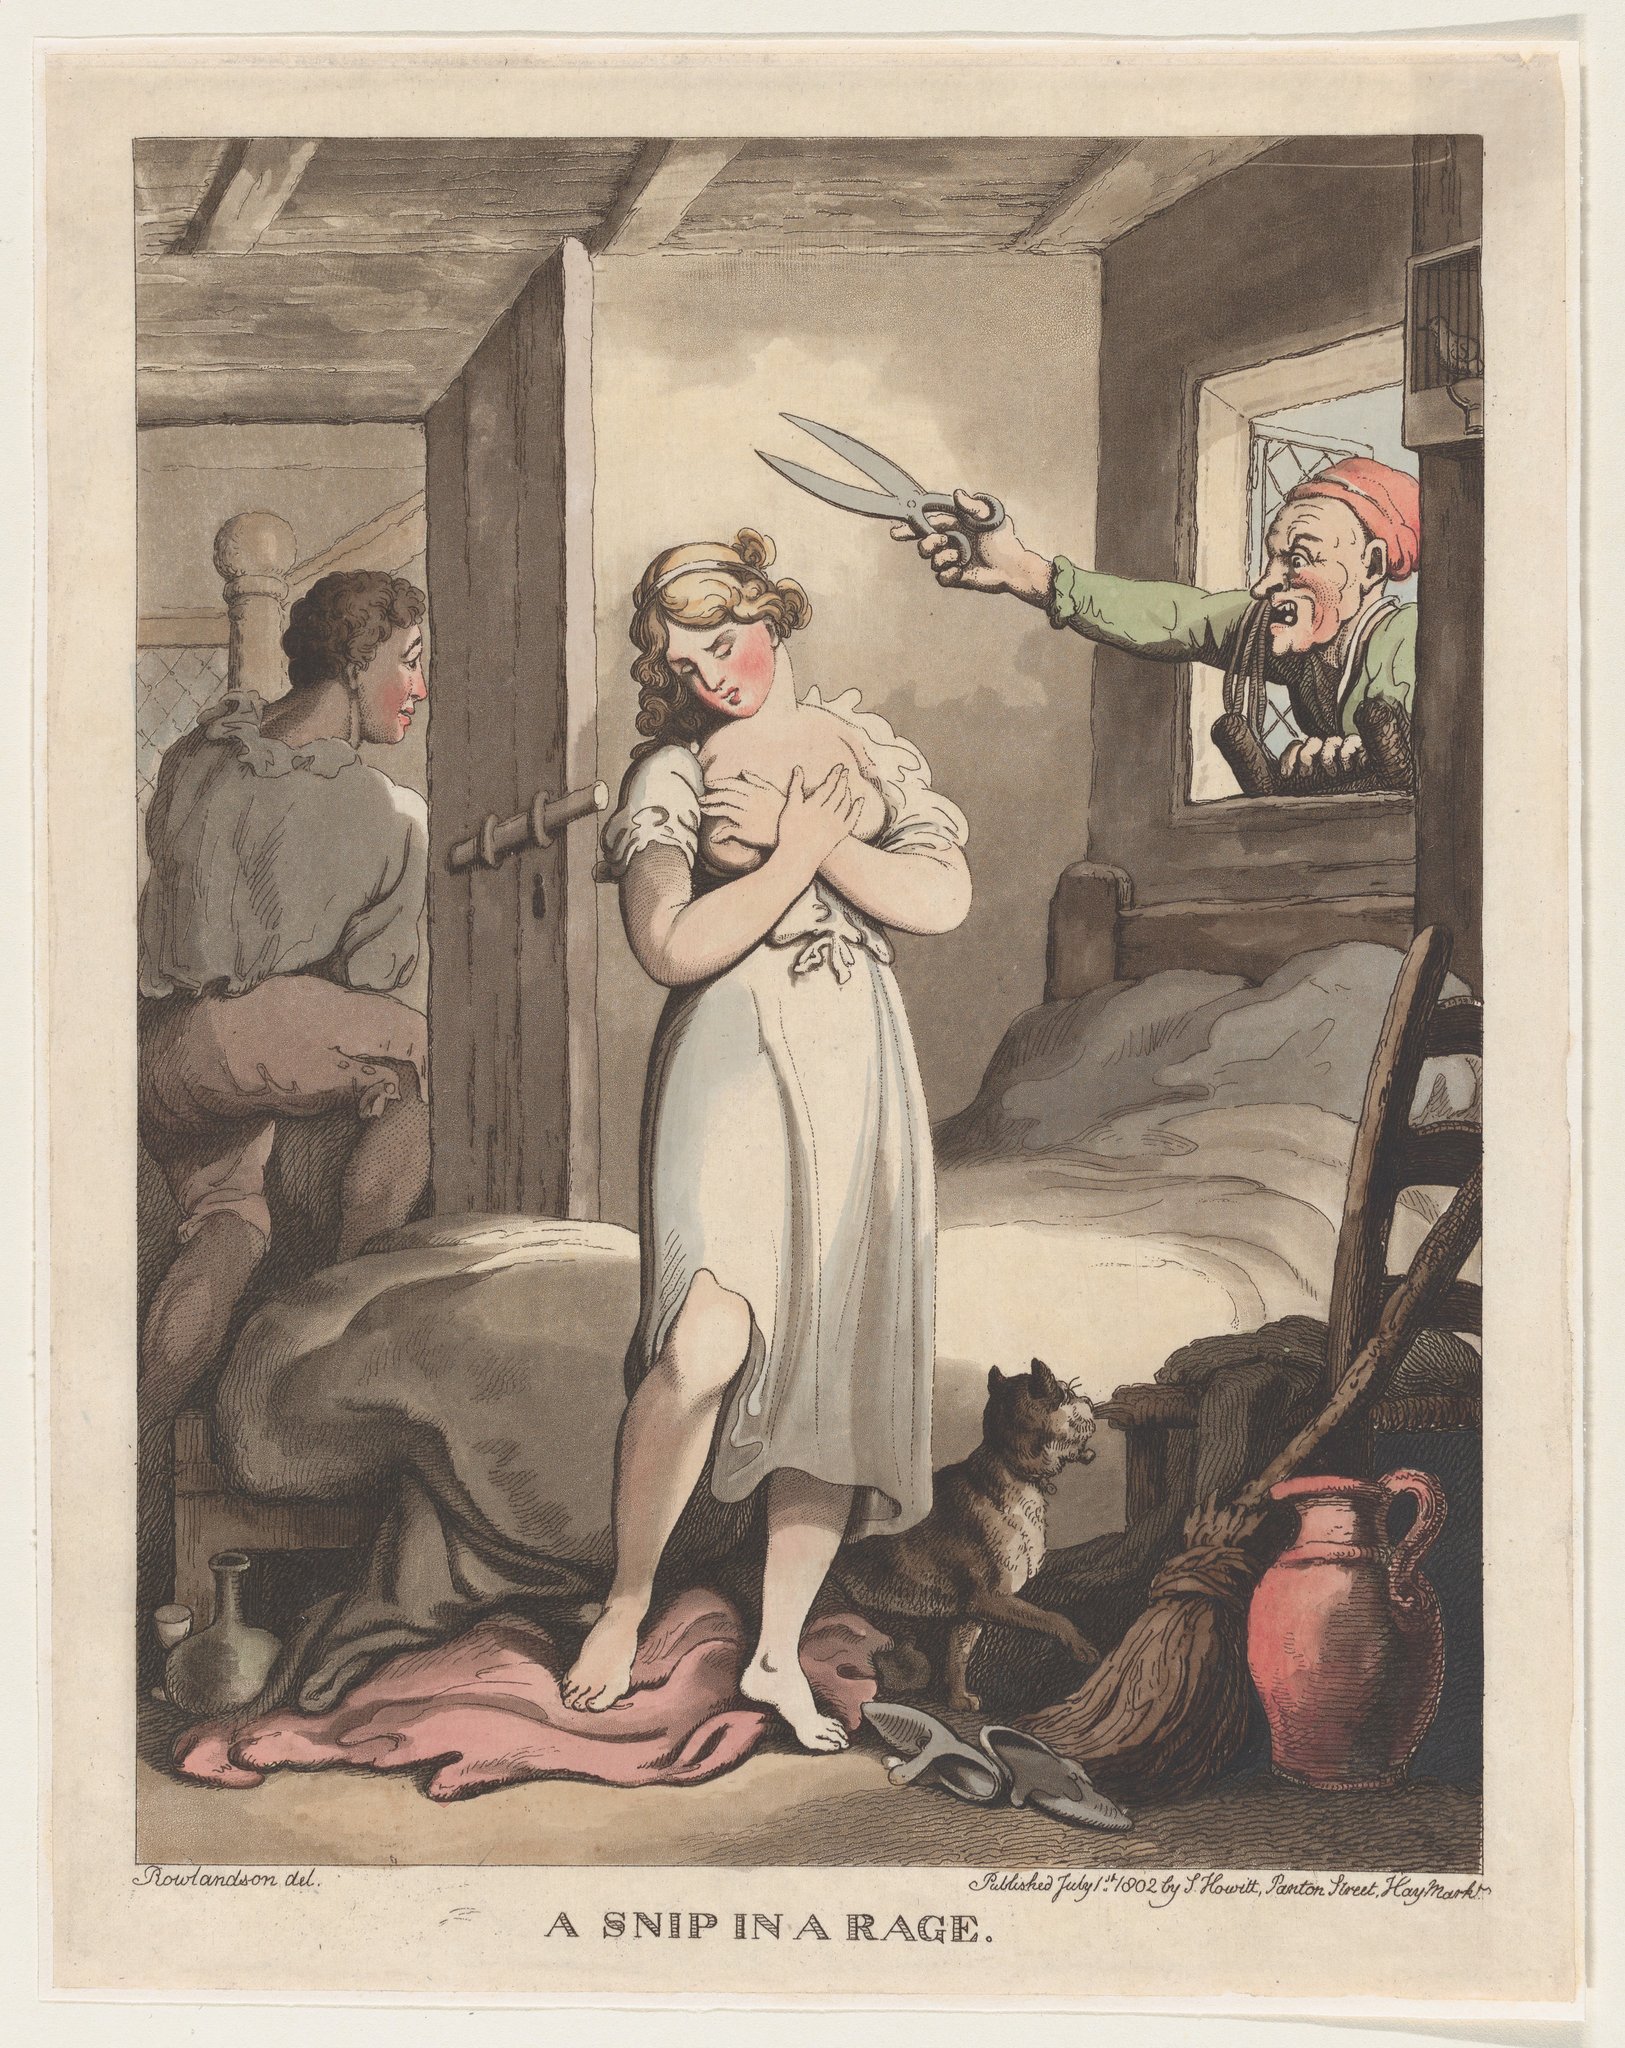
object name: print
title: A Snip in a Rage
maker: thomas rowlandson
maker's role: artist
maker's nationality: british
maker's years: 1757-1827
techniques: etching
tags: men,women,cats,beds,scissors